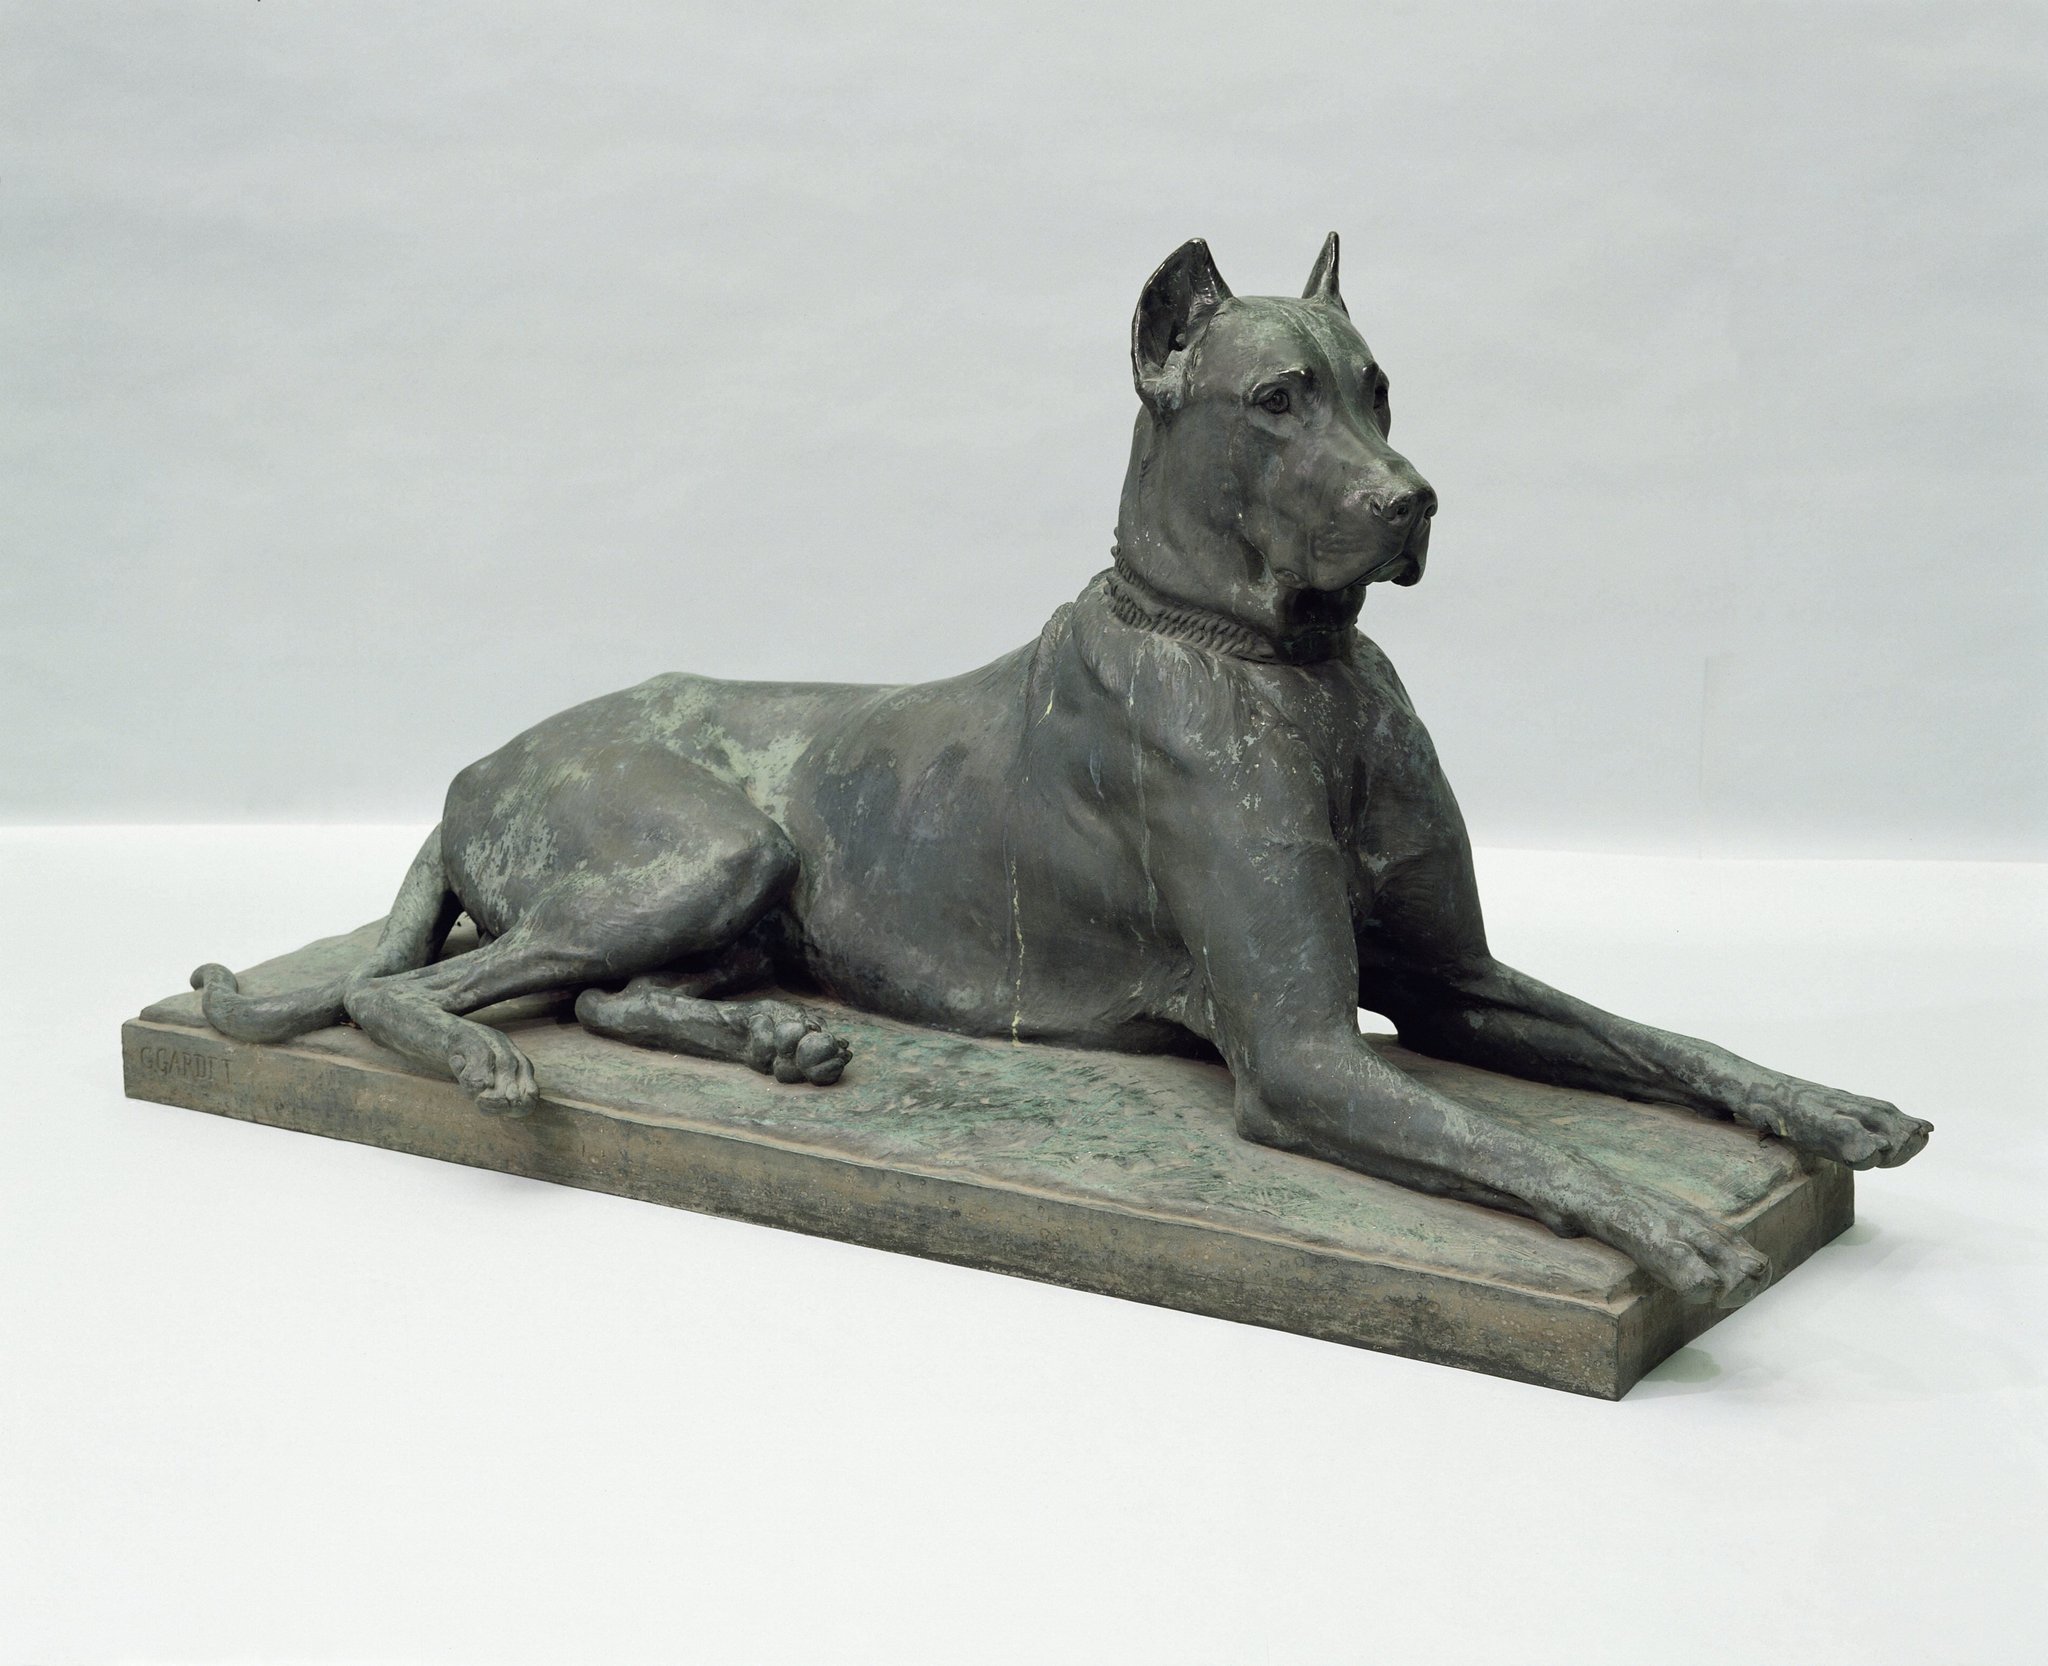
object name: sculpture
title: Deense dog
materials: bronze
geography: paris